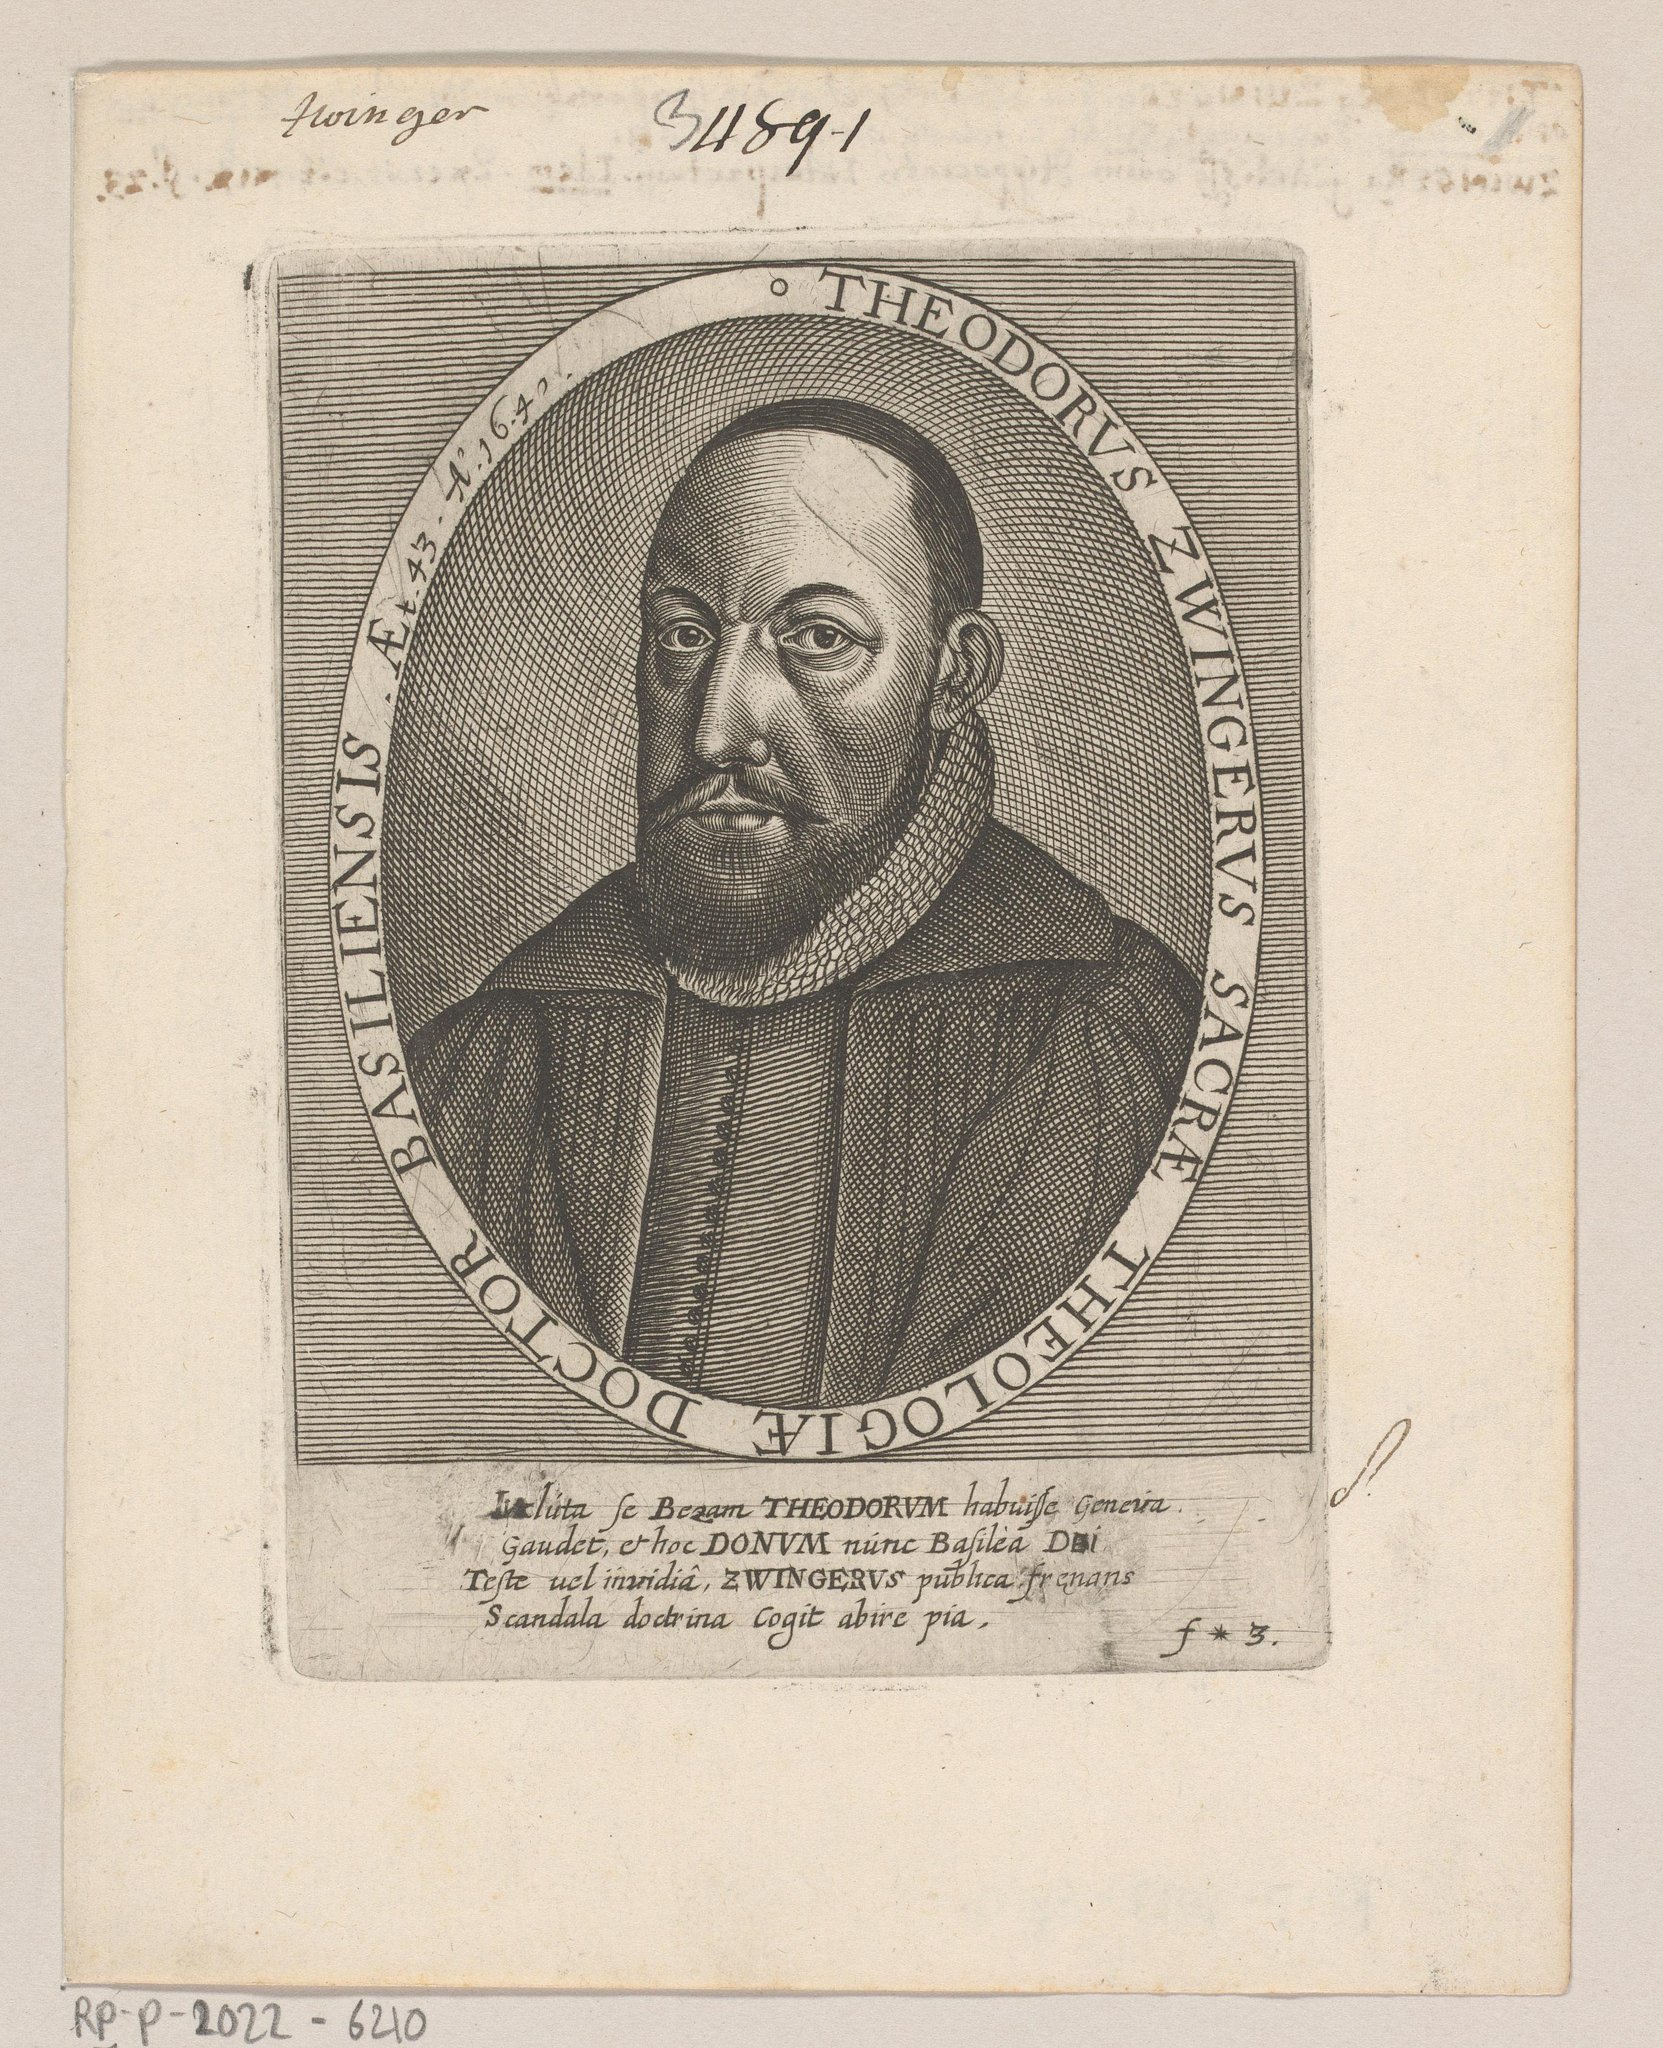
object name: book illustration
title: Bibliotheca chalcographica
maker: Anonymous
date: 1654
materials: paper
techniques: engraving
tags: scholar, philosopher, historical persons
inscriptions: inscription: ‘Zwinger 3489-1’, inscription: ‘Theodor Zwinger, leu! quant, e quàm ingparatilis viz. Joh. Antoni. van der Linden. Exercitat. IV. de Circuitu Sanguin [...] 48. Zwinger, fidelis [...] oium Hippocratis Interpretum. Idem. Exercit.cit.XIX.[...]23.’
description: Prent waarschijnlijk uit: Boissard, Jean Jacques. Bibliotheca chalcographica (...) Frankfurt am Main: Johannes Ammon, 1654, dl. 9.